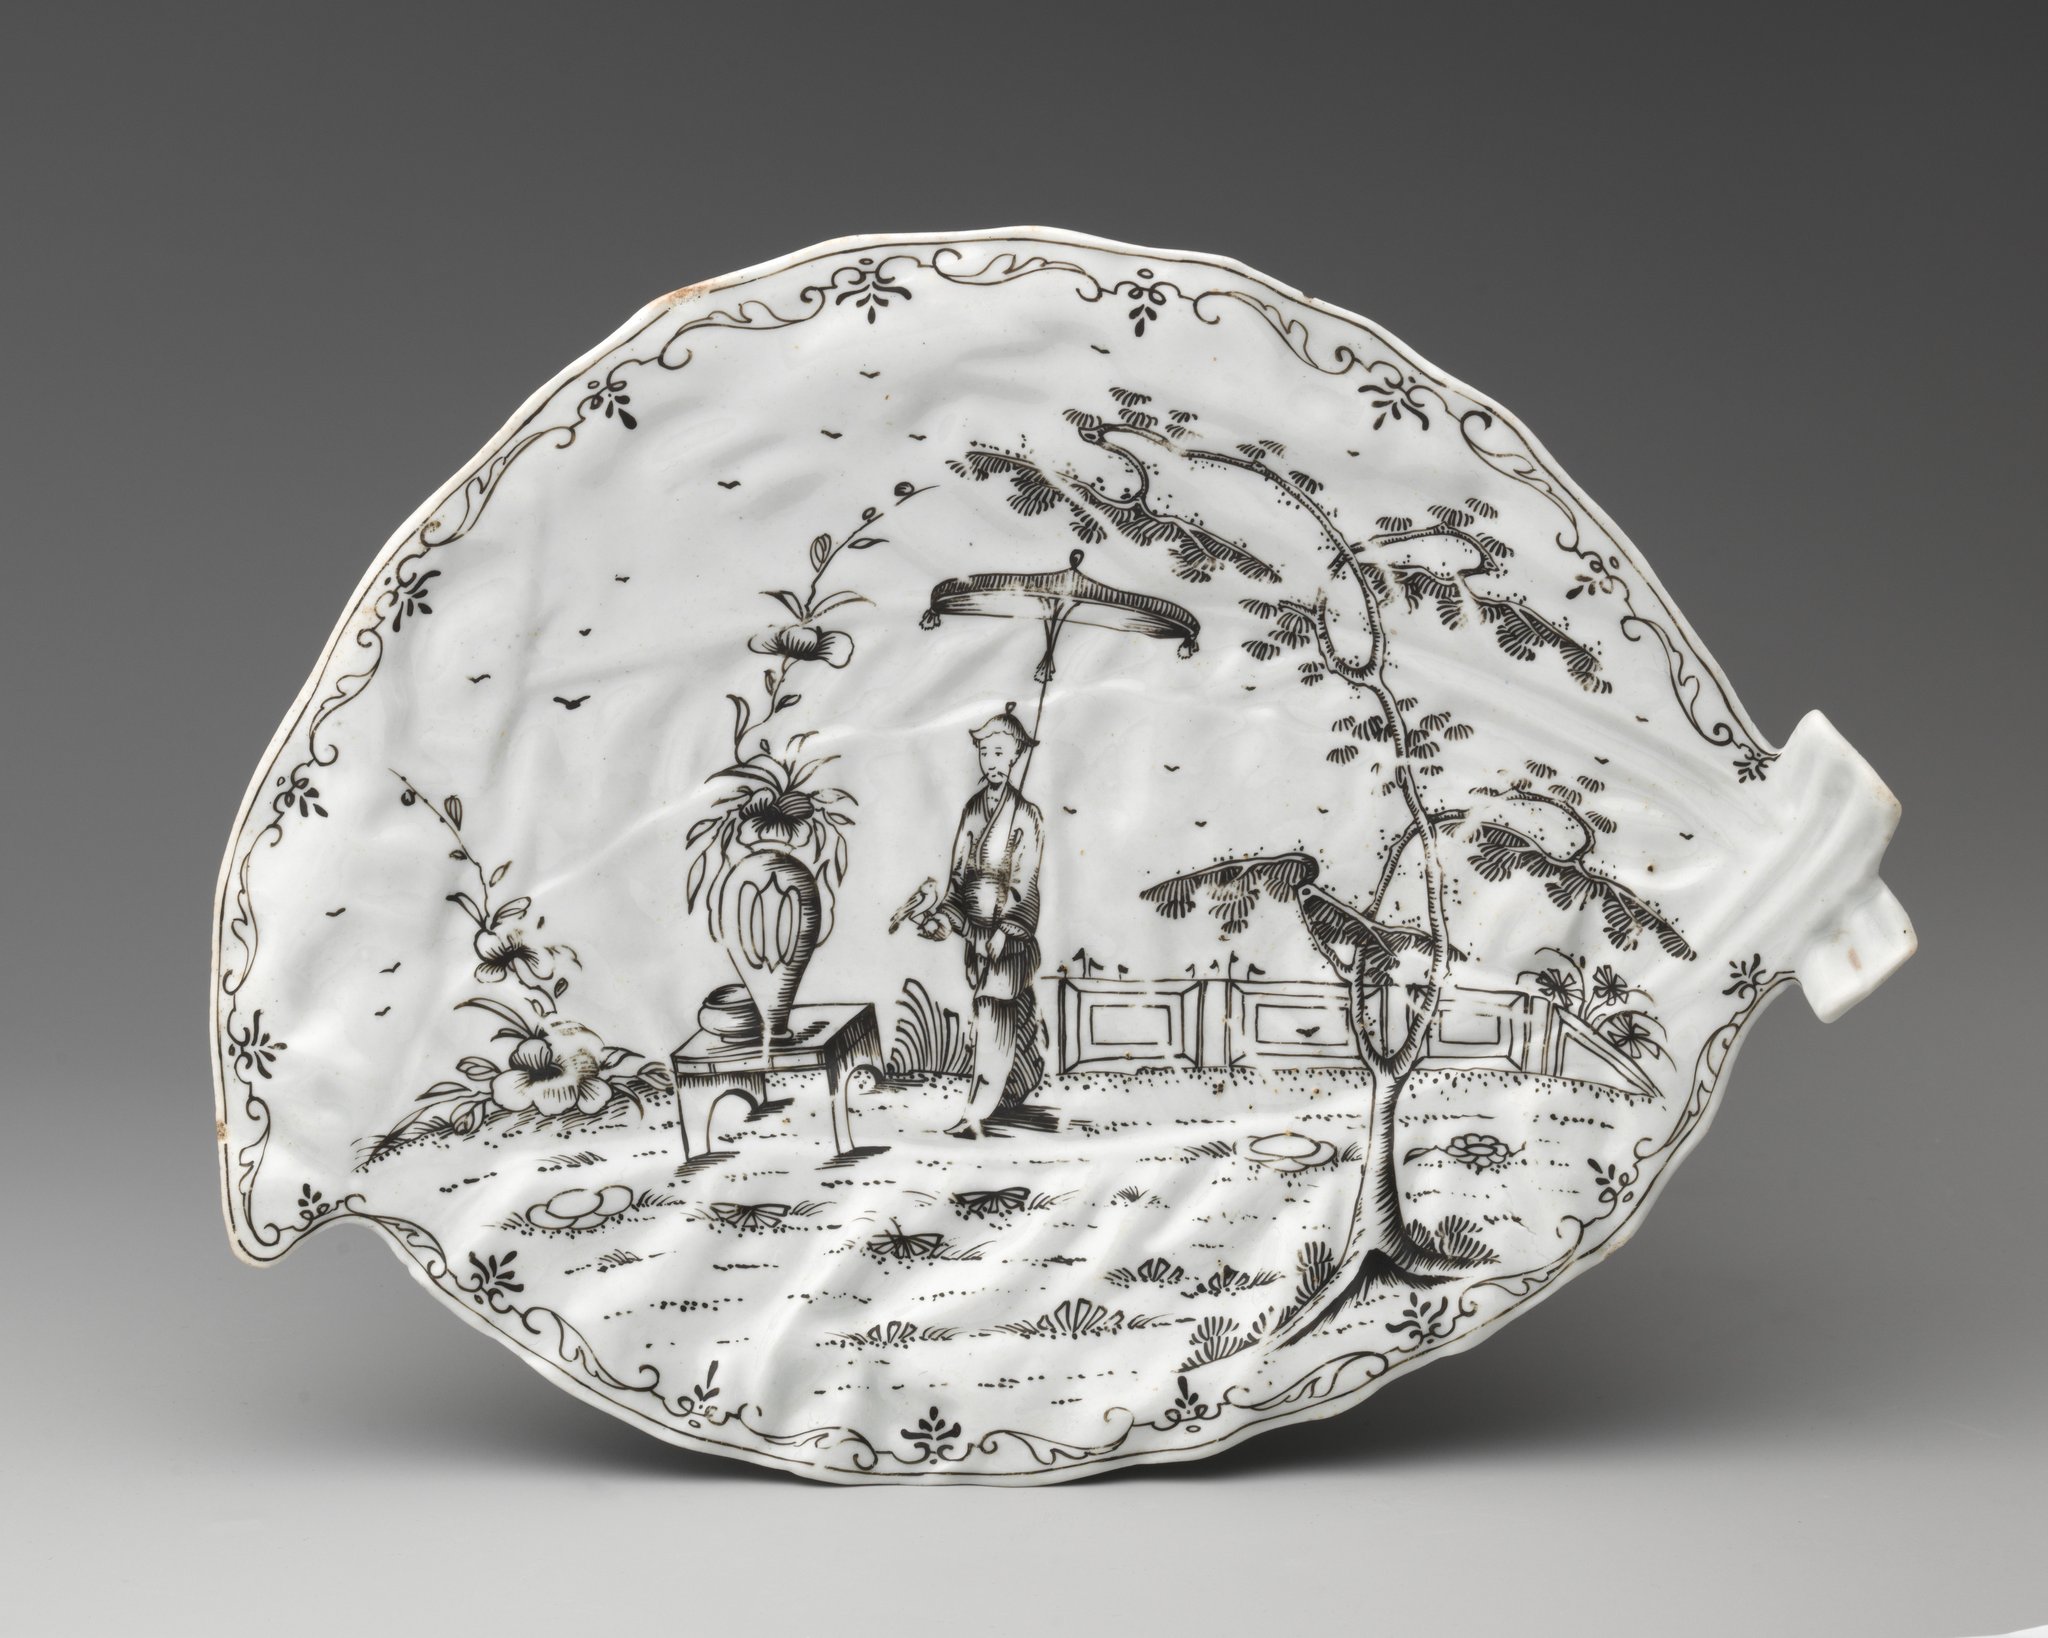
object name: dish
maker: worcester factory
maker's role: factory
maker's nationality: british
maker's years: 1751-2008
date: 1760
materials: soft paste porcelain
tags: chinoiserie,men